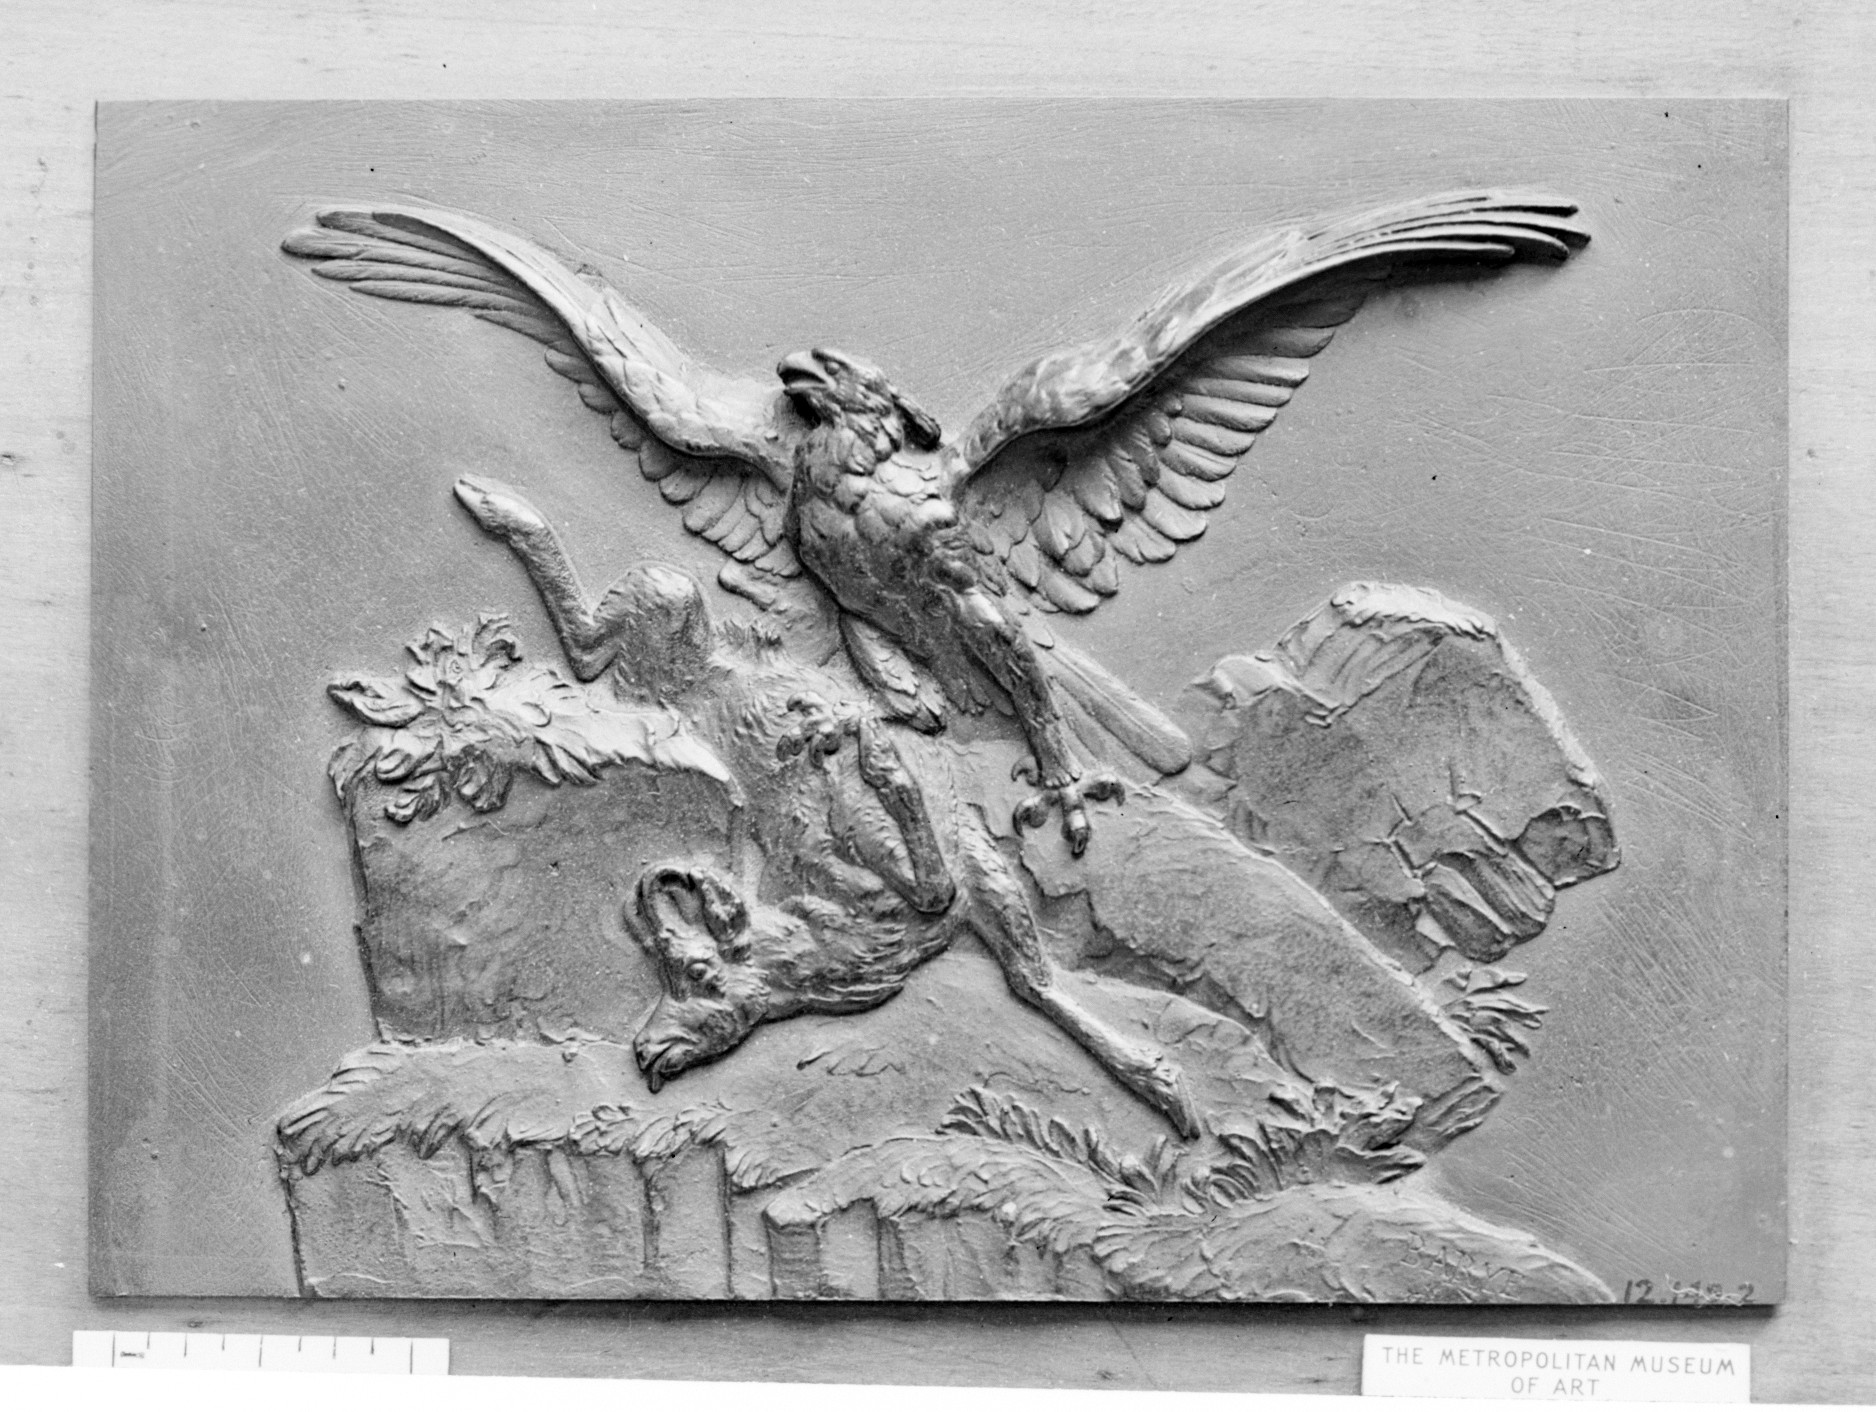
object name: plaquette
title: Eagle and Chamois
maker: antoine-louis barye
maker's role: artist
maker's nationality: french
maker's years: 1795-1875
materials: bronze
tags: animals,eagles